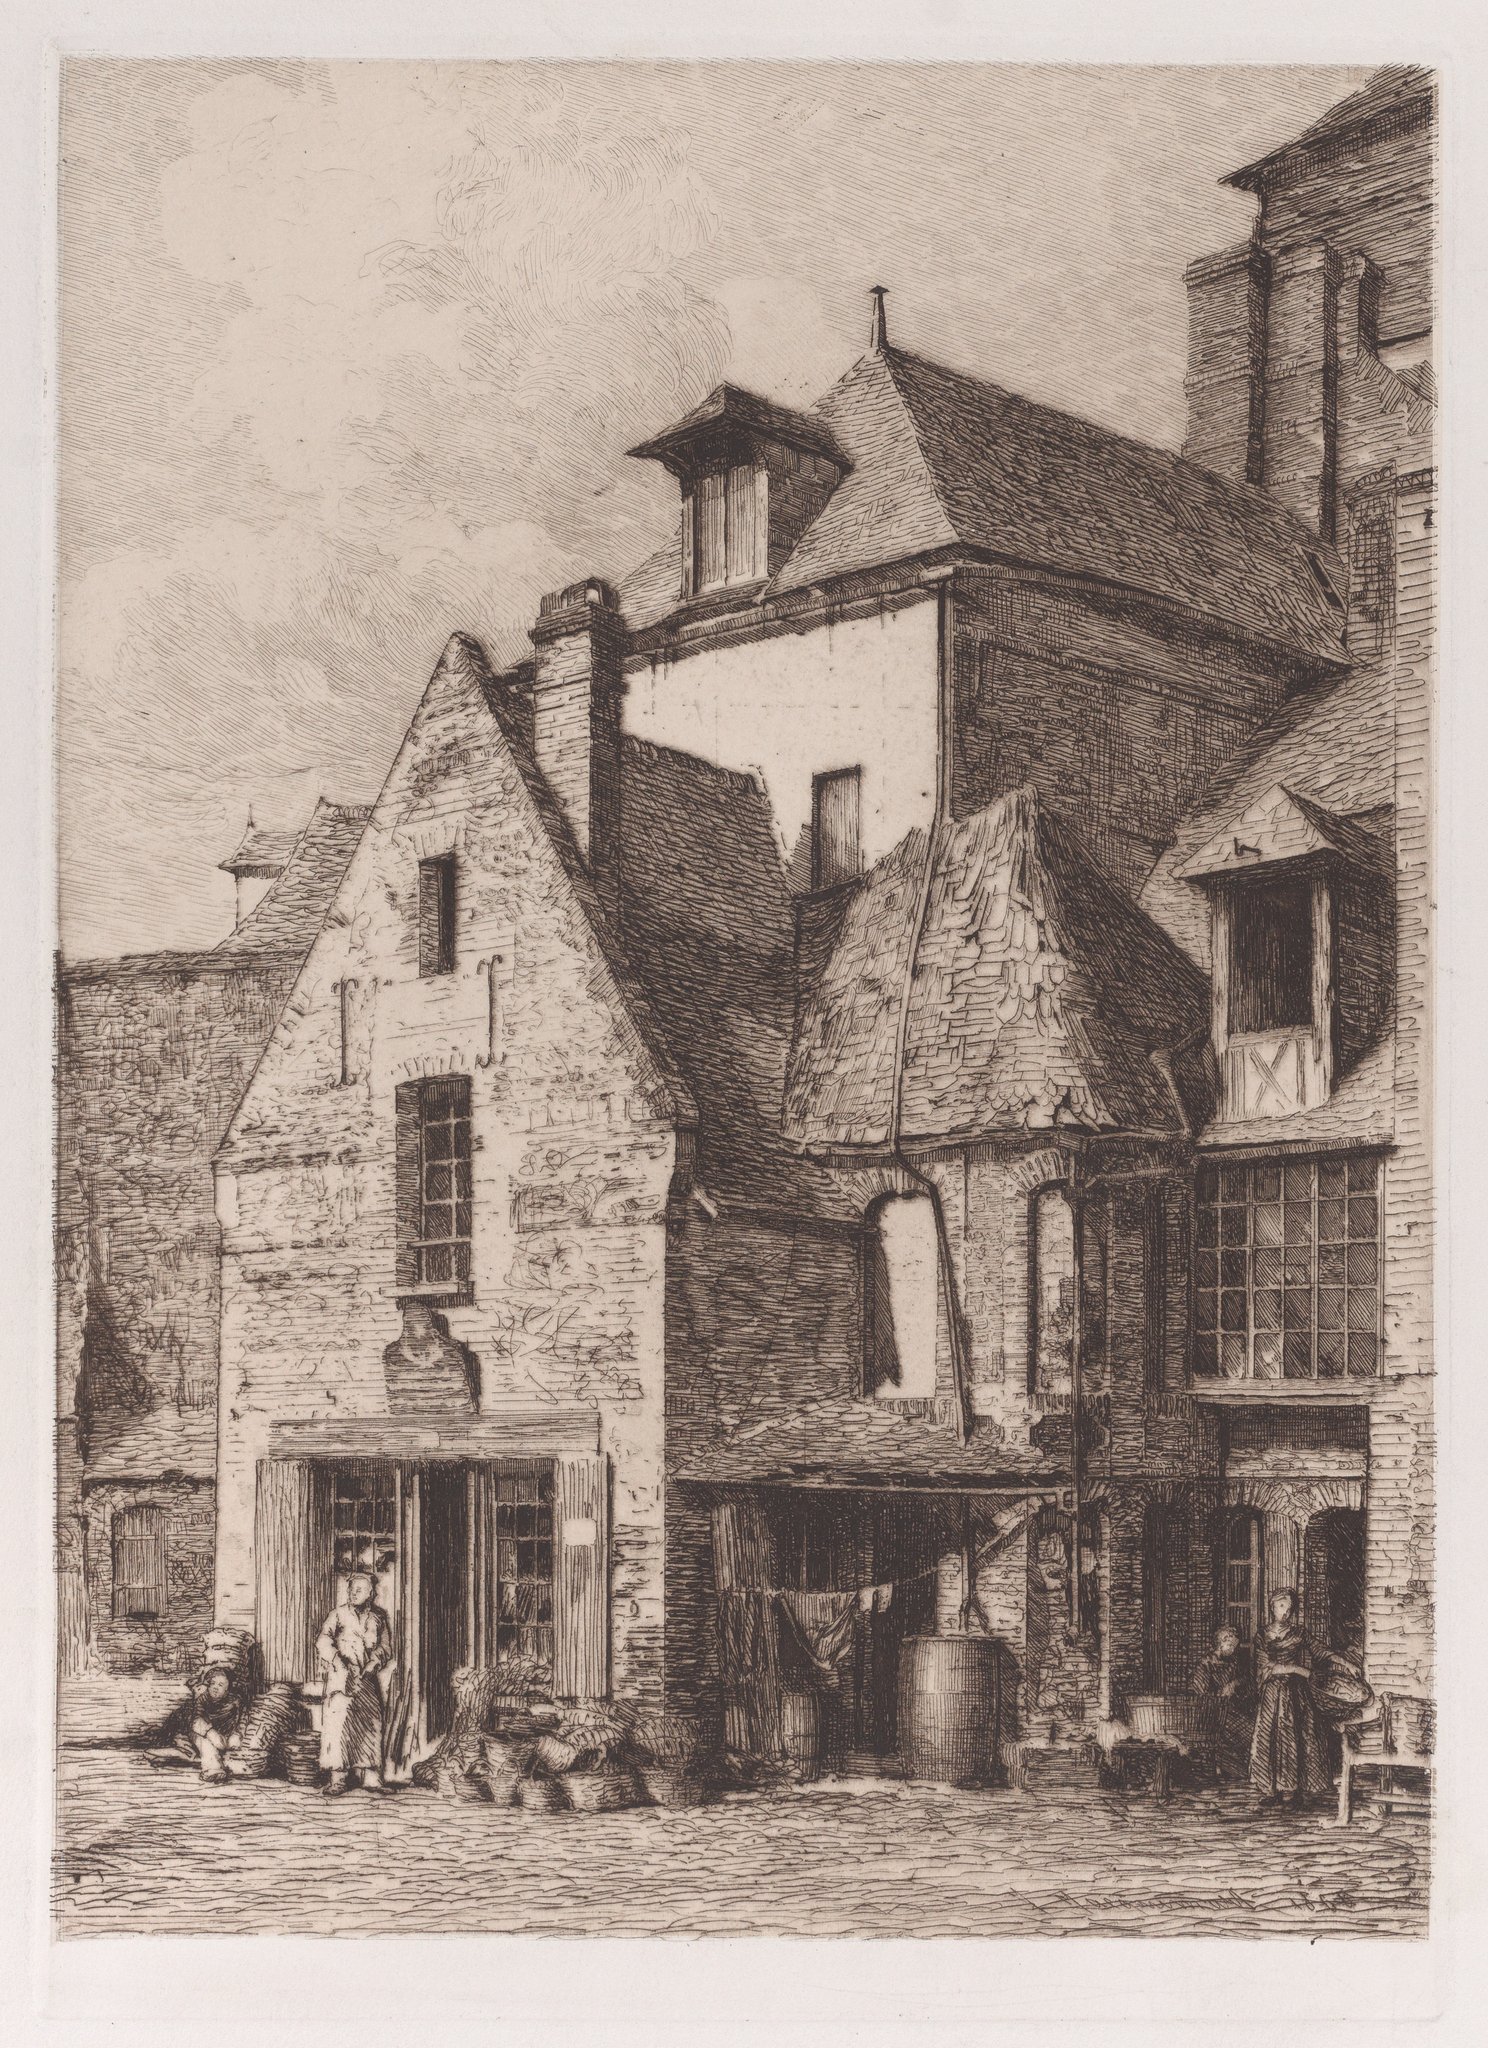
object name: print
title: The Old Market at Fecamp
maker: jules-ferdinand jacquemart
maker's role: artist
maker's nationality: french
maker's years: 1837-1880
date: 1865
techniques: etching